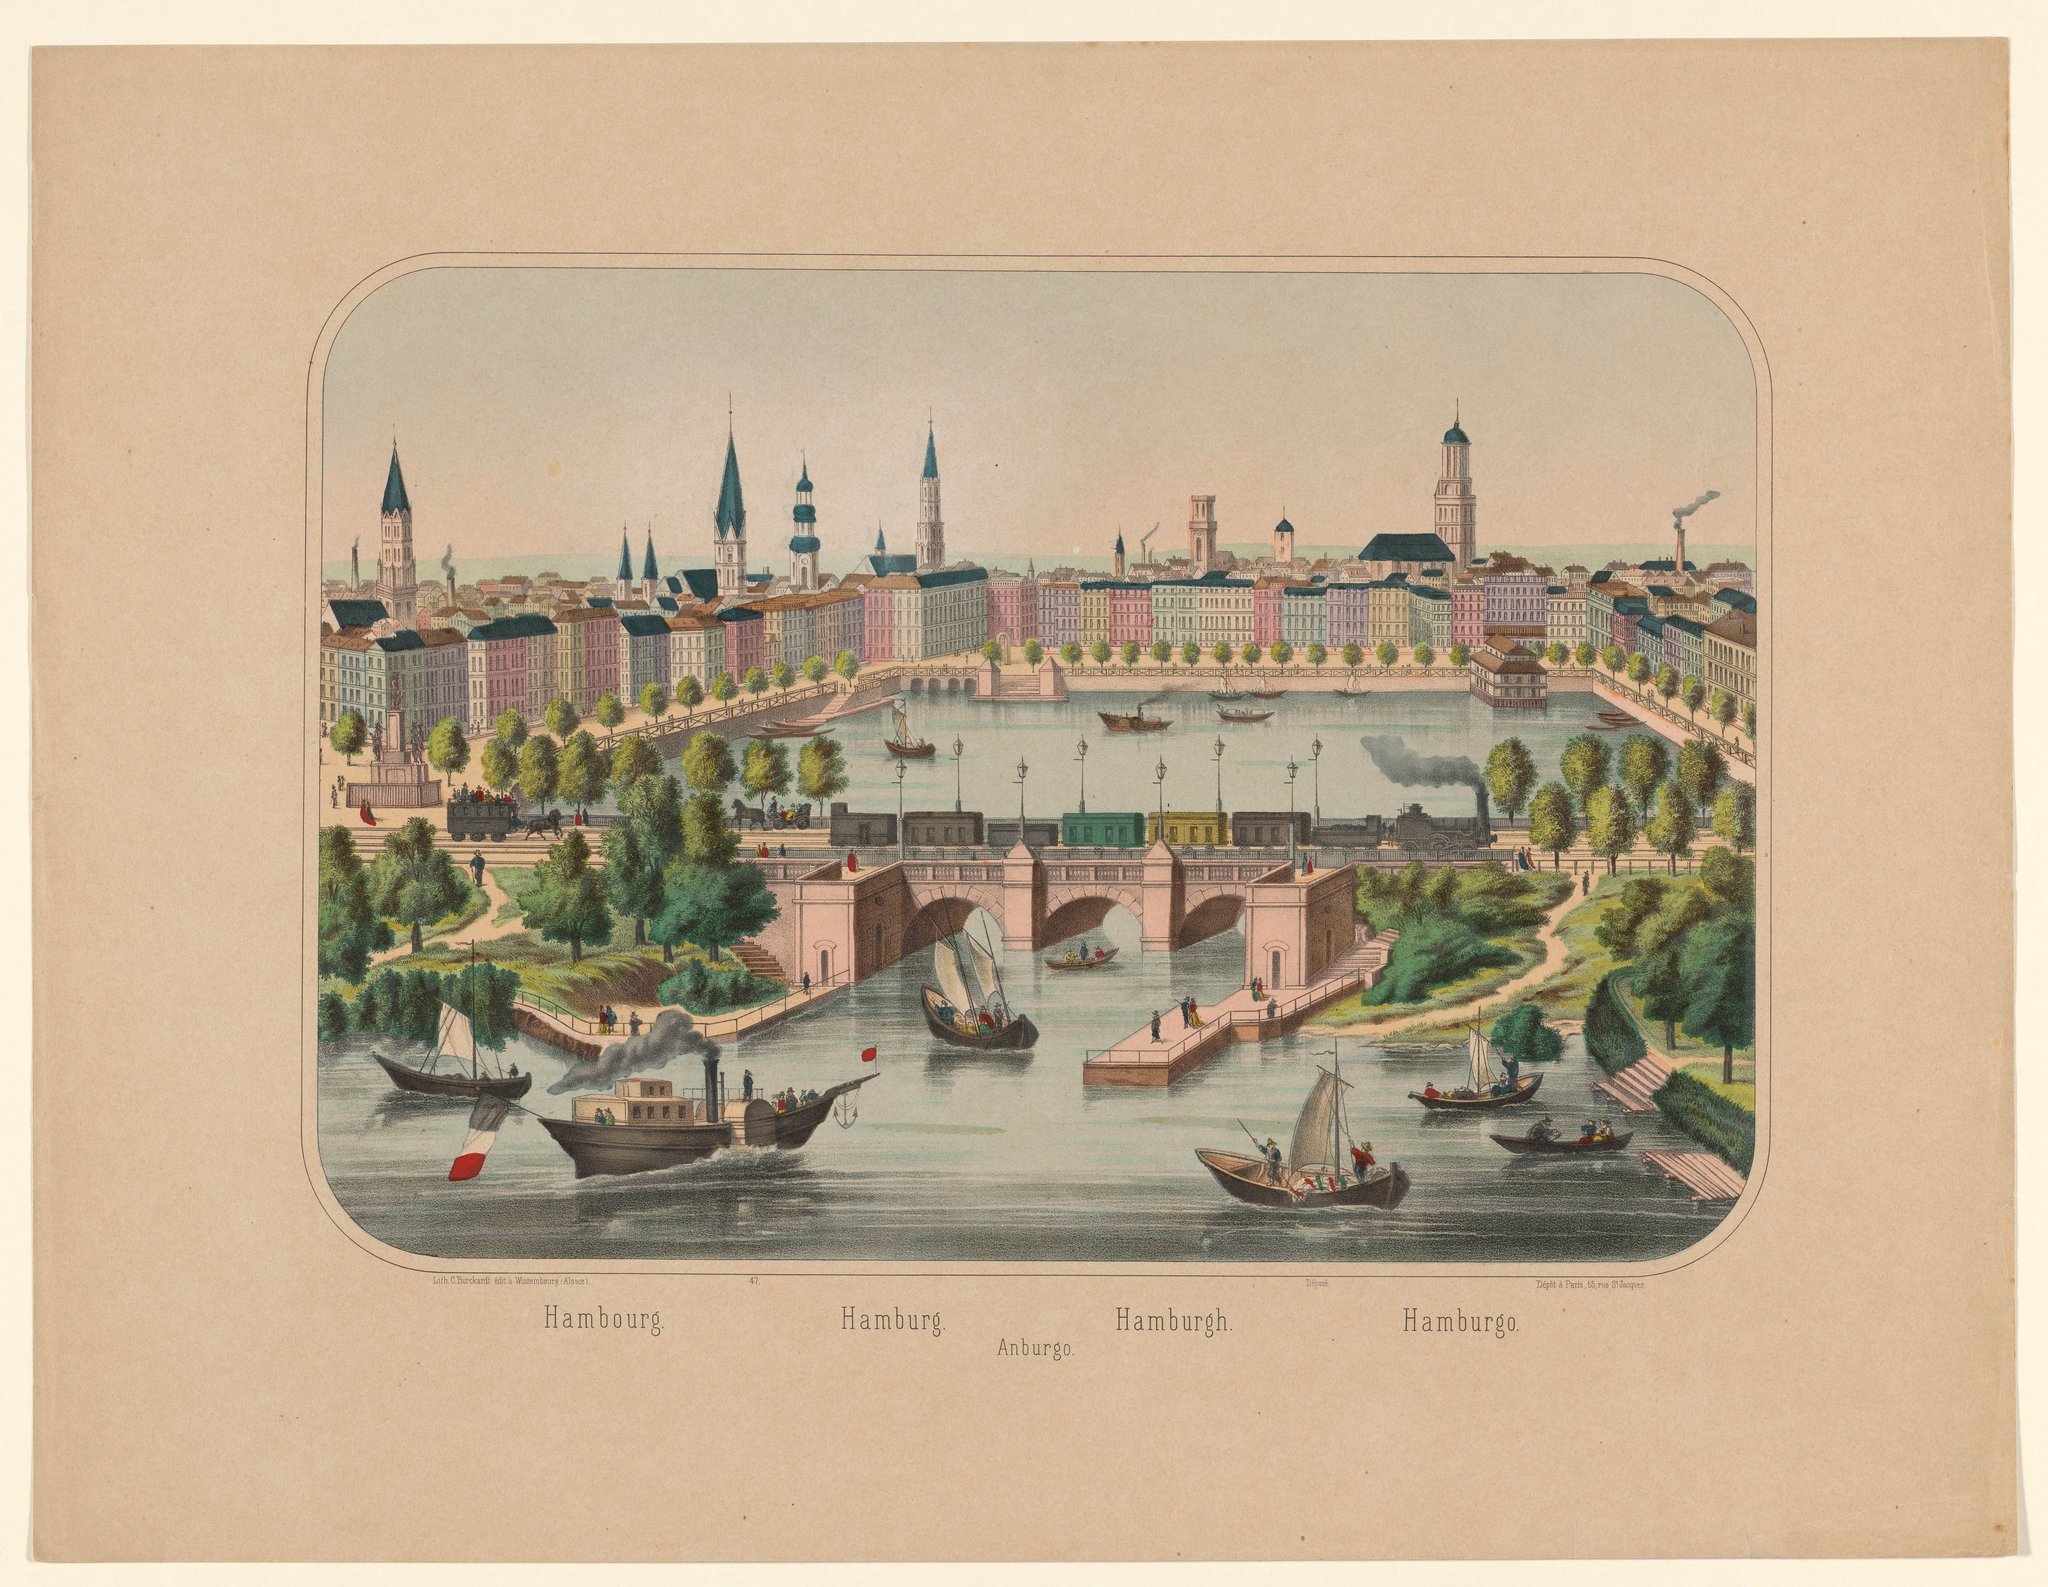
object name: print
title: Hambourg / Hamburg / Anburgo / Hamburgh / Hamburgo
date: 1870-1889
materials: paper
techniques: lithograph, hand coloring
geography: weissenburg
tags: sailing-ship, sailing-boat, pond, steamship, motorship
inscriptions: collector's mark: Lugt 2233, : ‘Déposé’